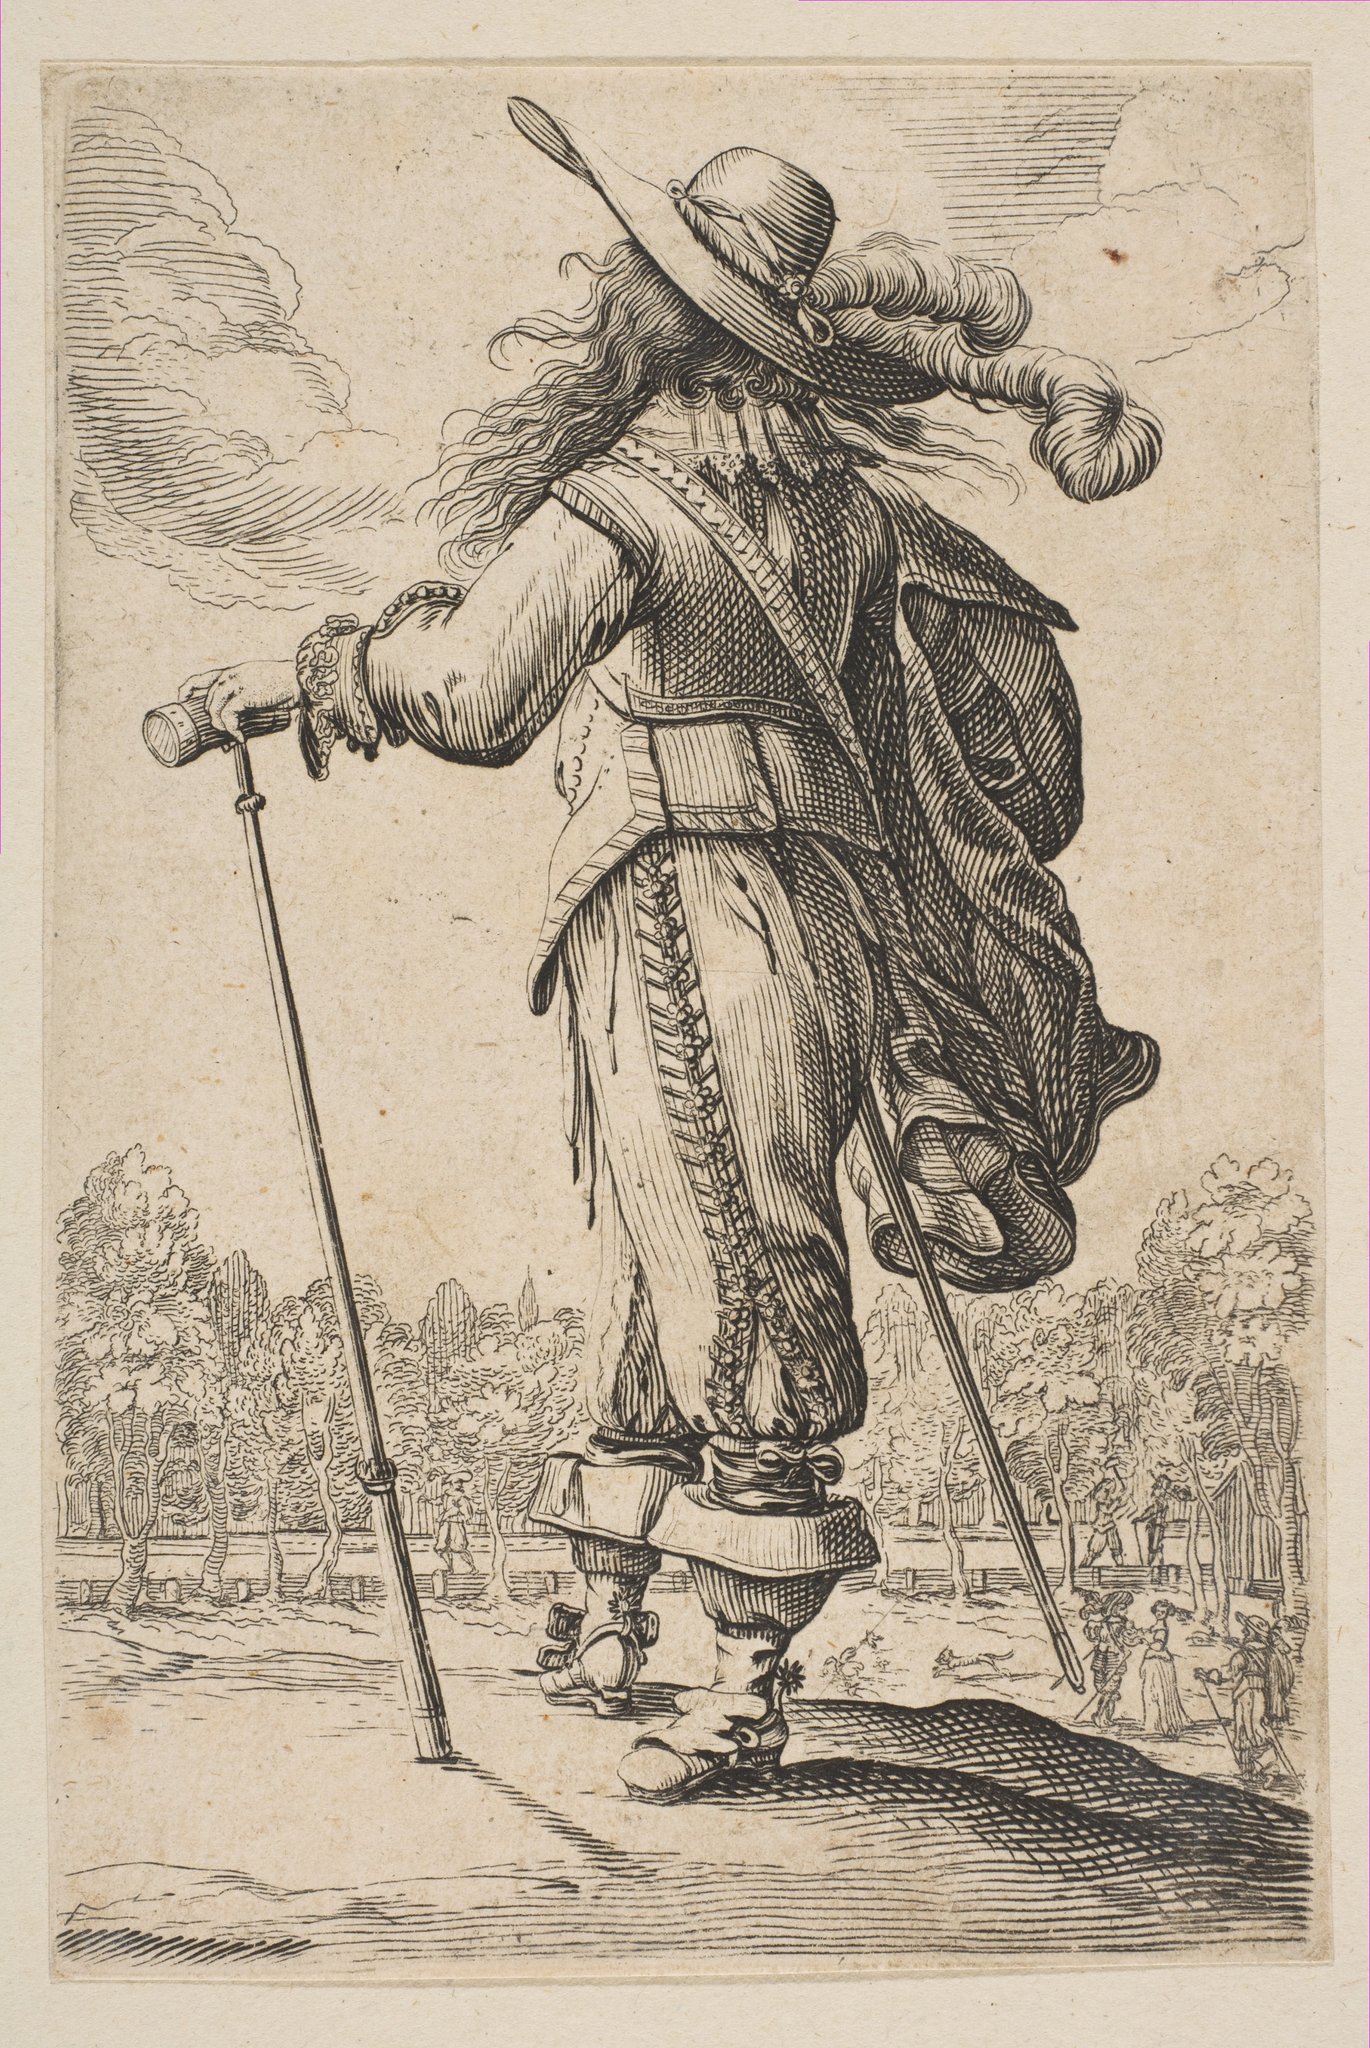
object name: print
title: A Man Seen from the Back Leaning on a Cane or Mallet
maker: anonymous, french, 17th century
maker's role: artist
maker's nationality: french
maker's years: 1600-1700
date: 1629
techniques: etching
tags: men